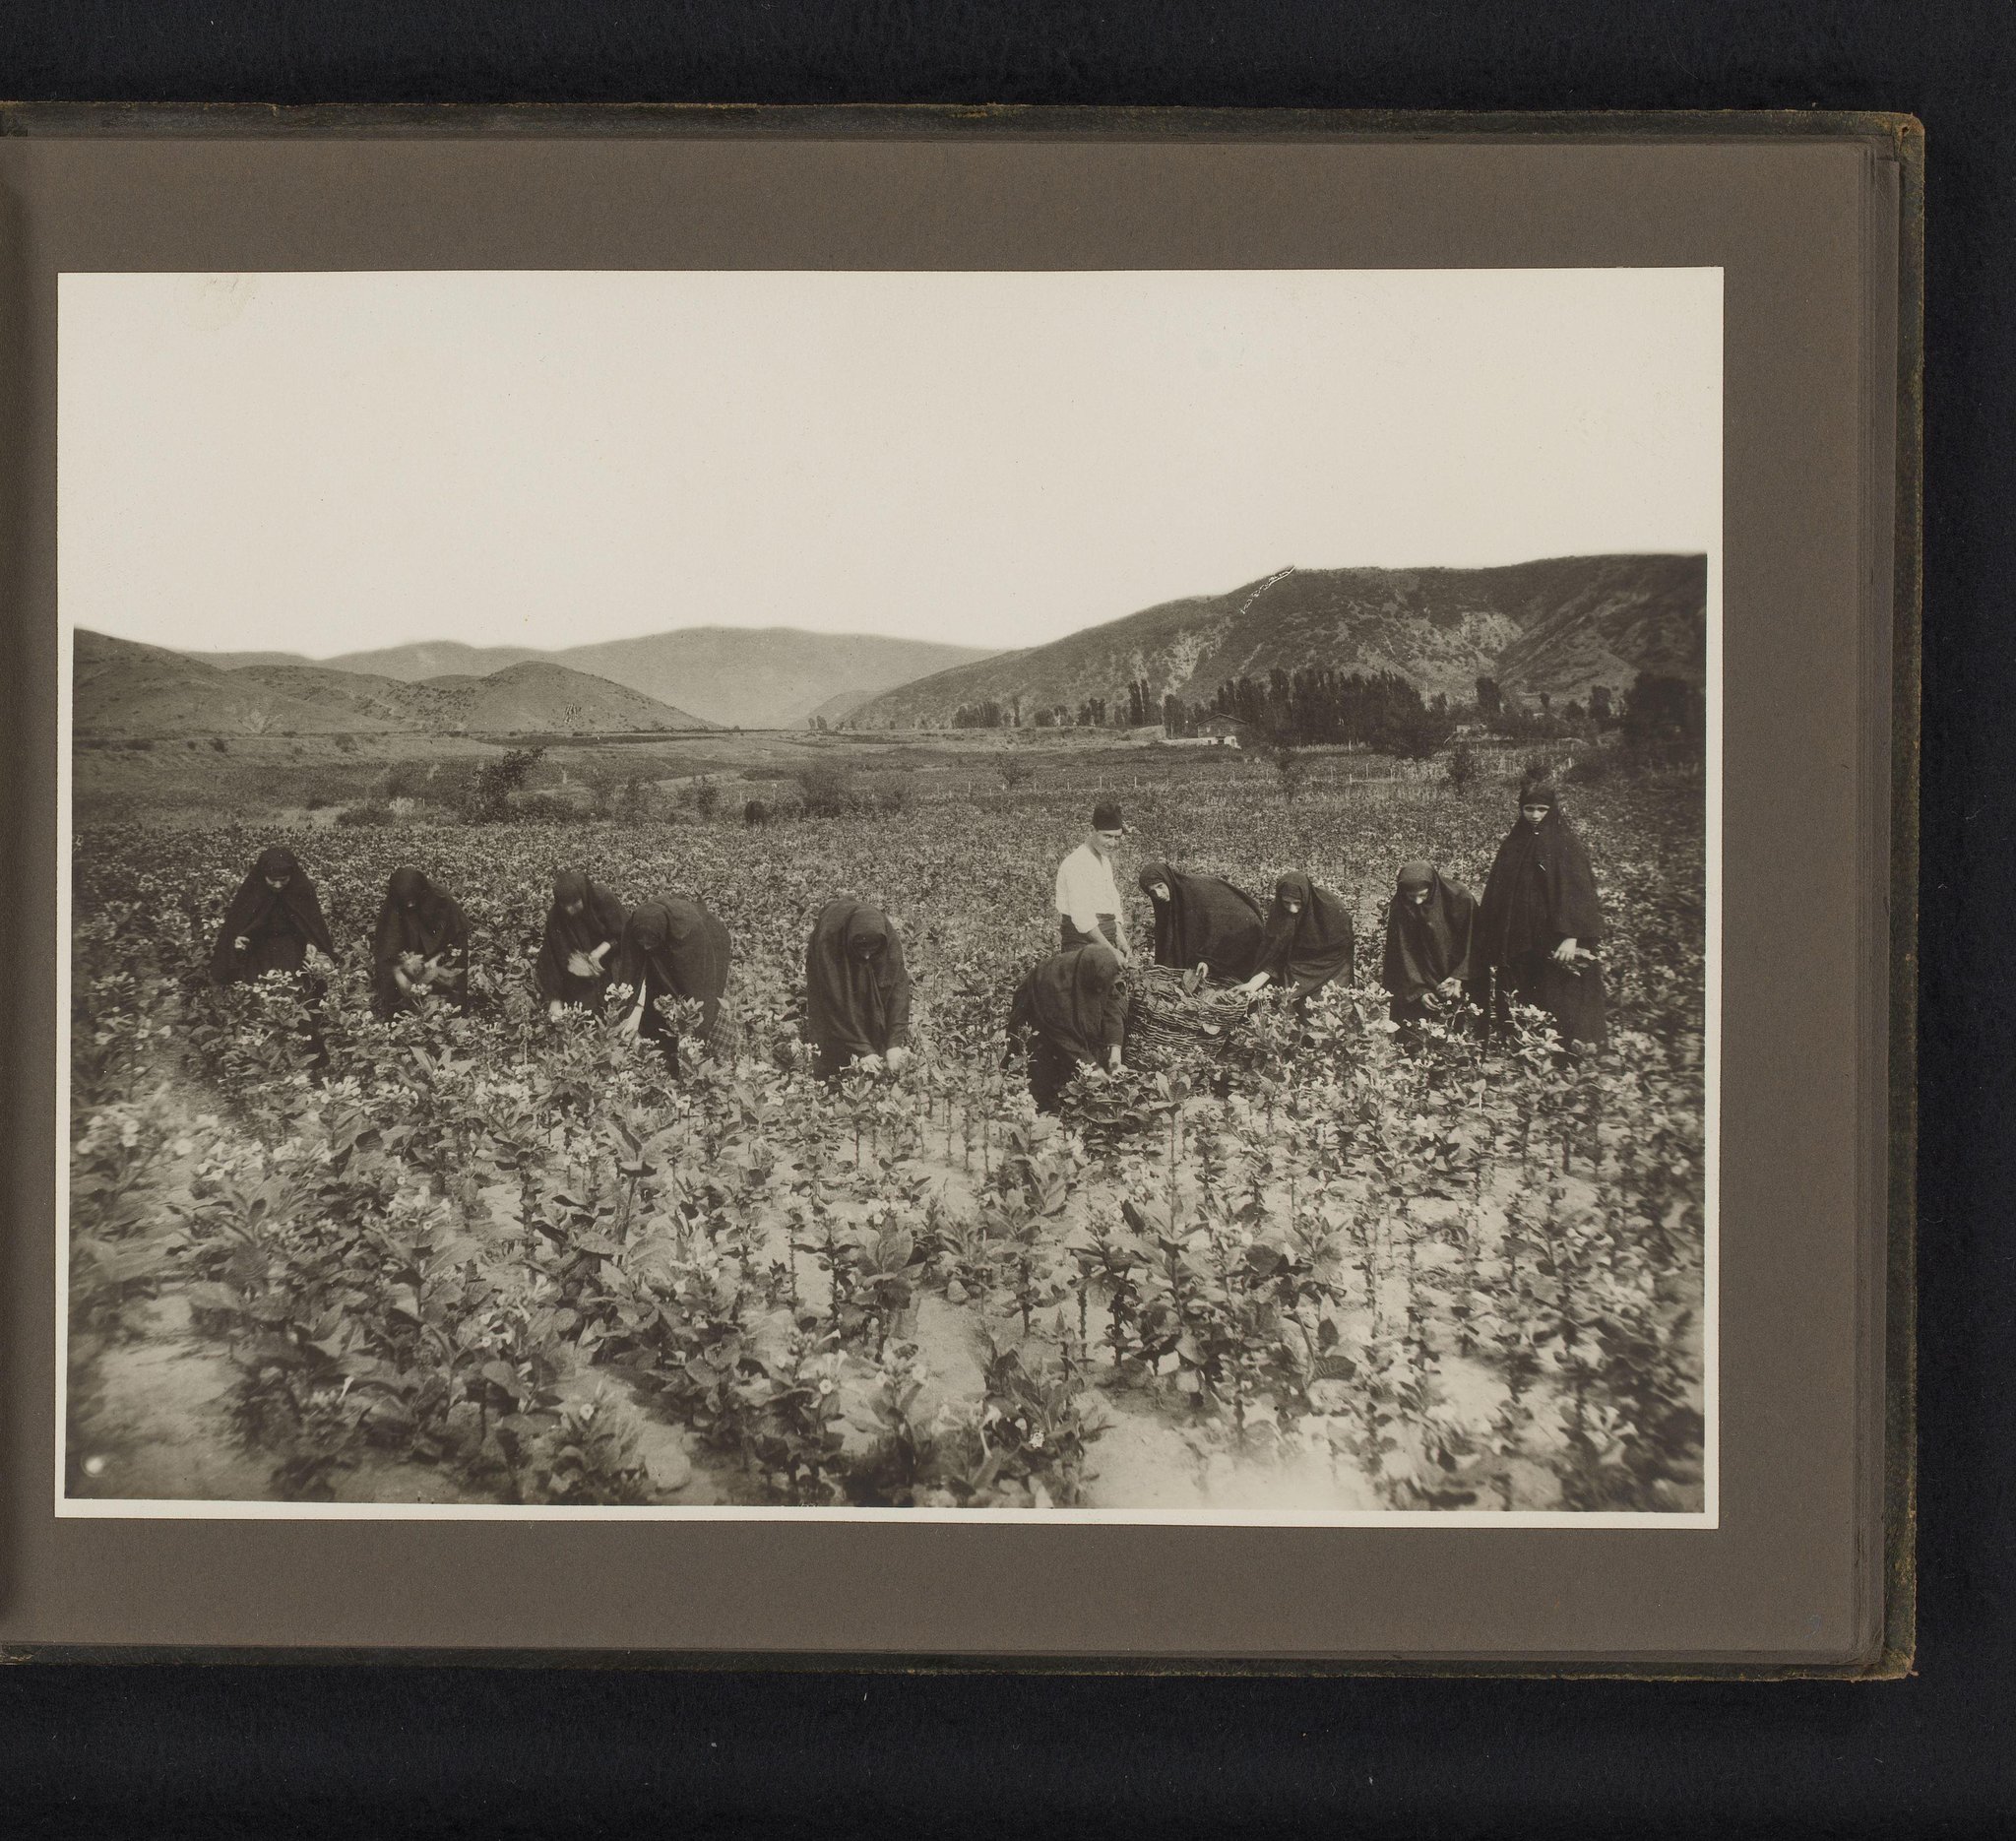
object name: photograph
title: Oogsten van tabak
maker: Anonymous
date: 1925-1928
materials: cardboard, photographic support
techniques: gelatin silver print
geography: bulgaria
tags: eugen wachenheimer, islam, mohammedanism, harvest, (non-fruit) products of plants or trees: tobacco, clothes covering the entire body (with name), folk costume, regional costume, tobacco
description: Een groep islamitische vrouwen op het veld bezig met het oogsten van tabaksbladeren, allen dragen een chador. Onderdeel van het fotoalbum voor Eugen Wachenheimer bij zijn afscheid als directeur van het filiaal van de Deutsche Bank in Sofia, december 1928.